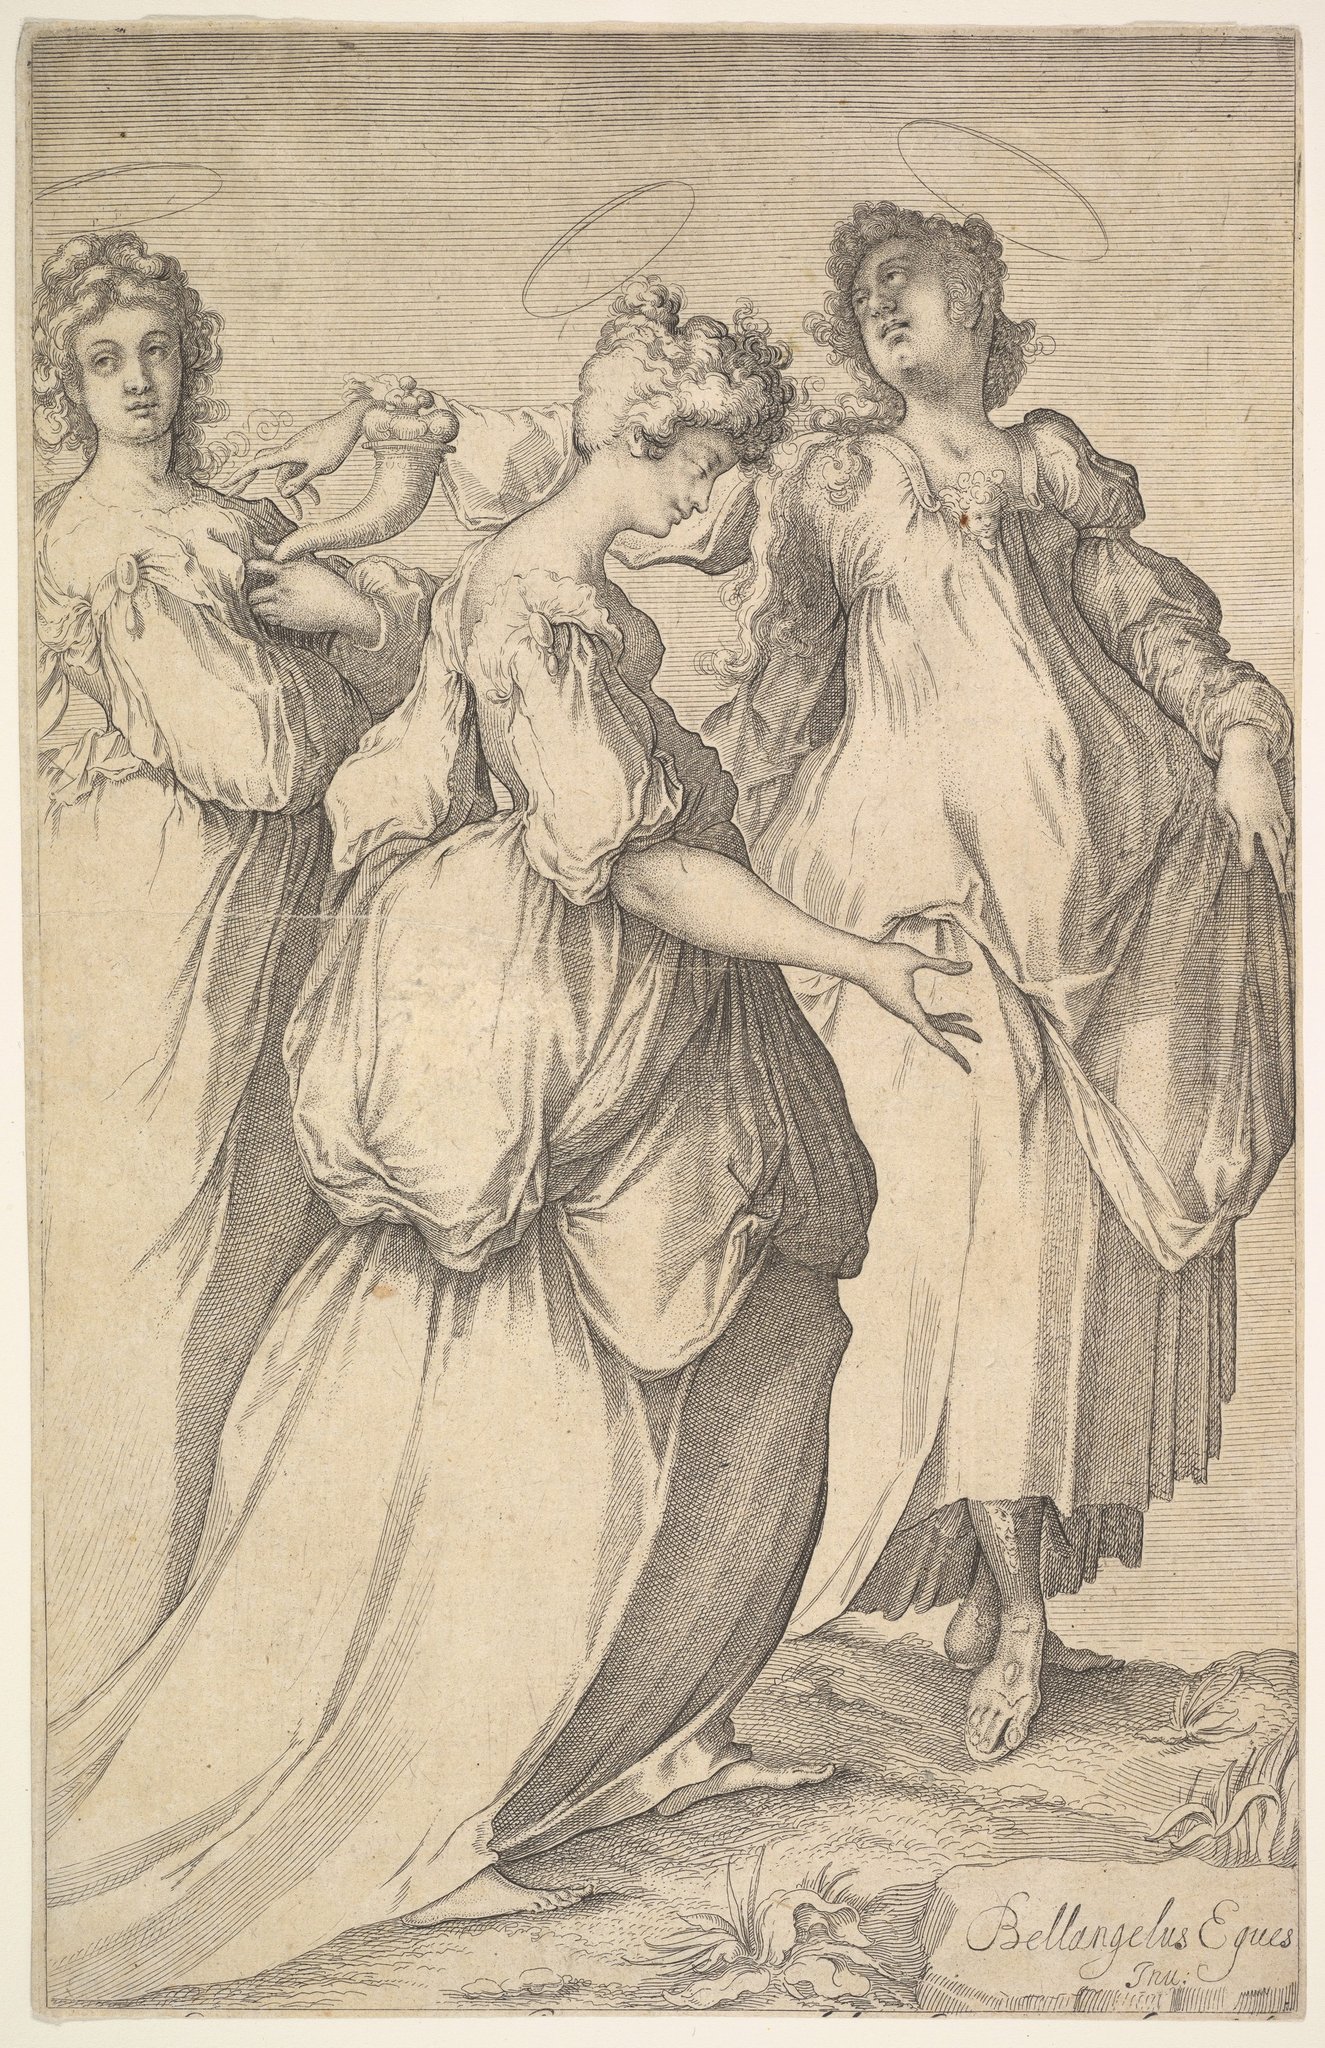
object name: print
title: Three Haloed Female Figures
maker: matthäus merian the elder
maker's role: artist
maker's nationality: swiss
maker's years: 1593-1650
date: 1610-1650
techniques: engraving, etching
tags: women